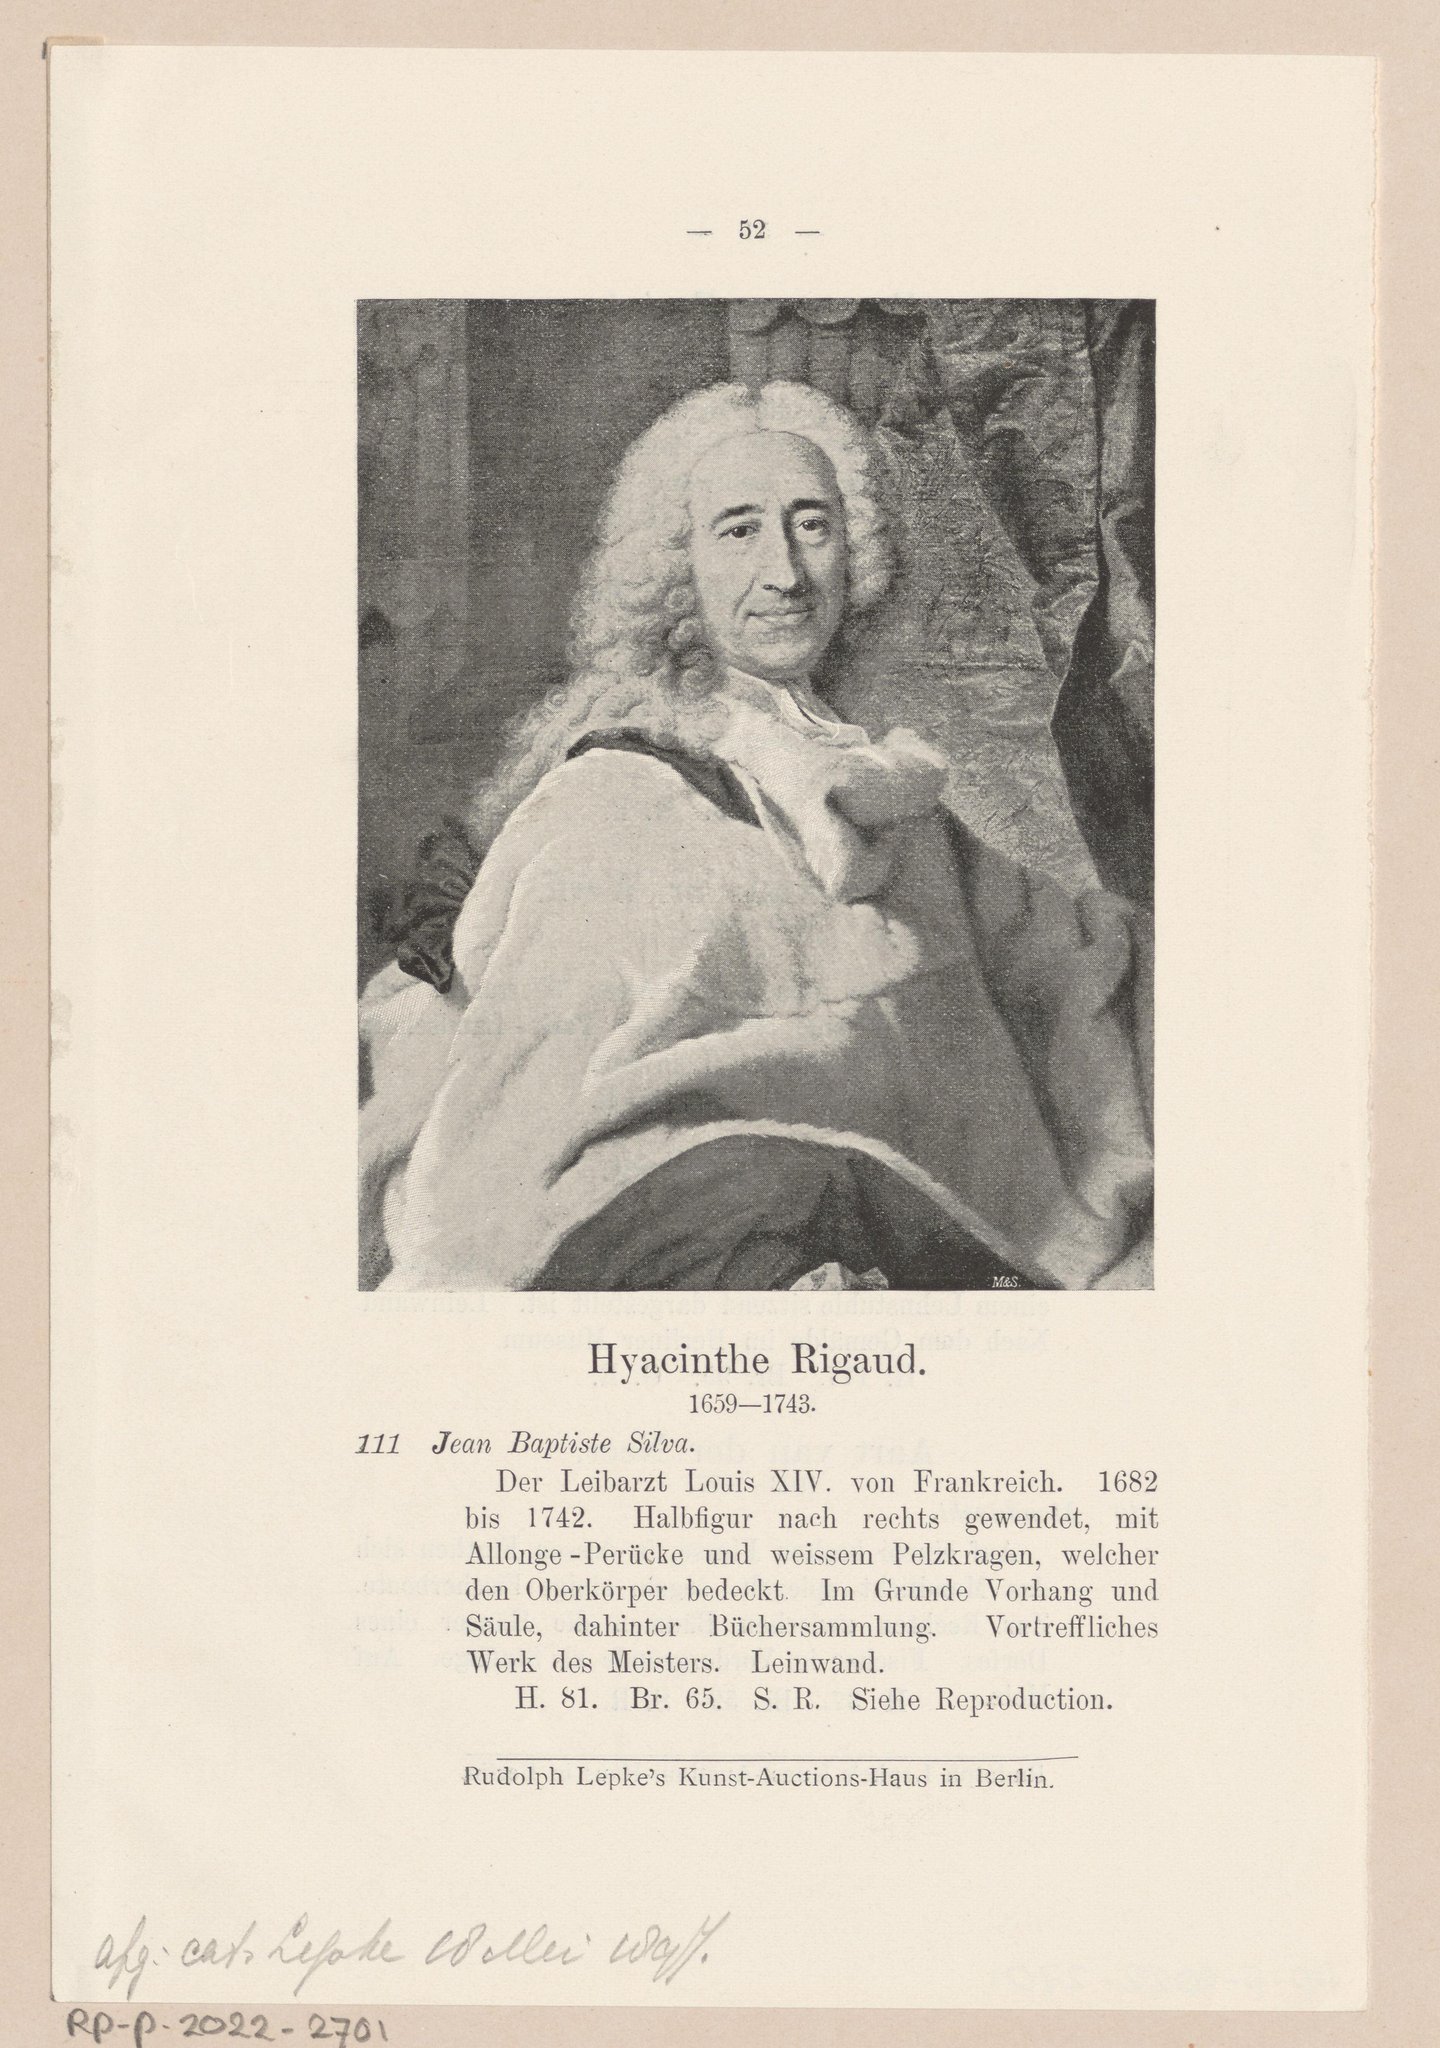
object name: photomechanical print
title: Portret van Jean-Baptiste Silva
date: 1882-1970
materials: paper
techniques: letterpress printing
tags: historical persons, physician, doctor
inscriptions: inscription: ‘afg: cat Lepke [...]lei [...]’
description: Fotomechanische afdruk uit een onbekende publicatie.